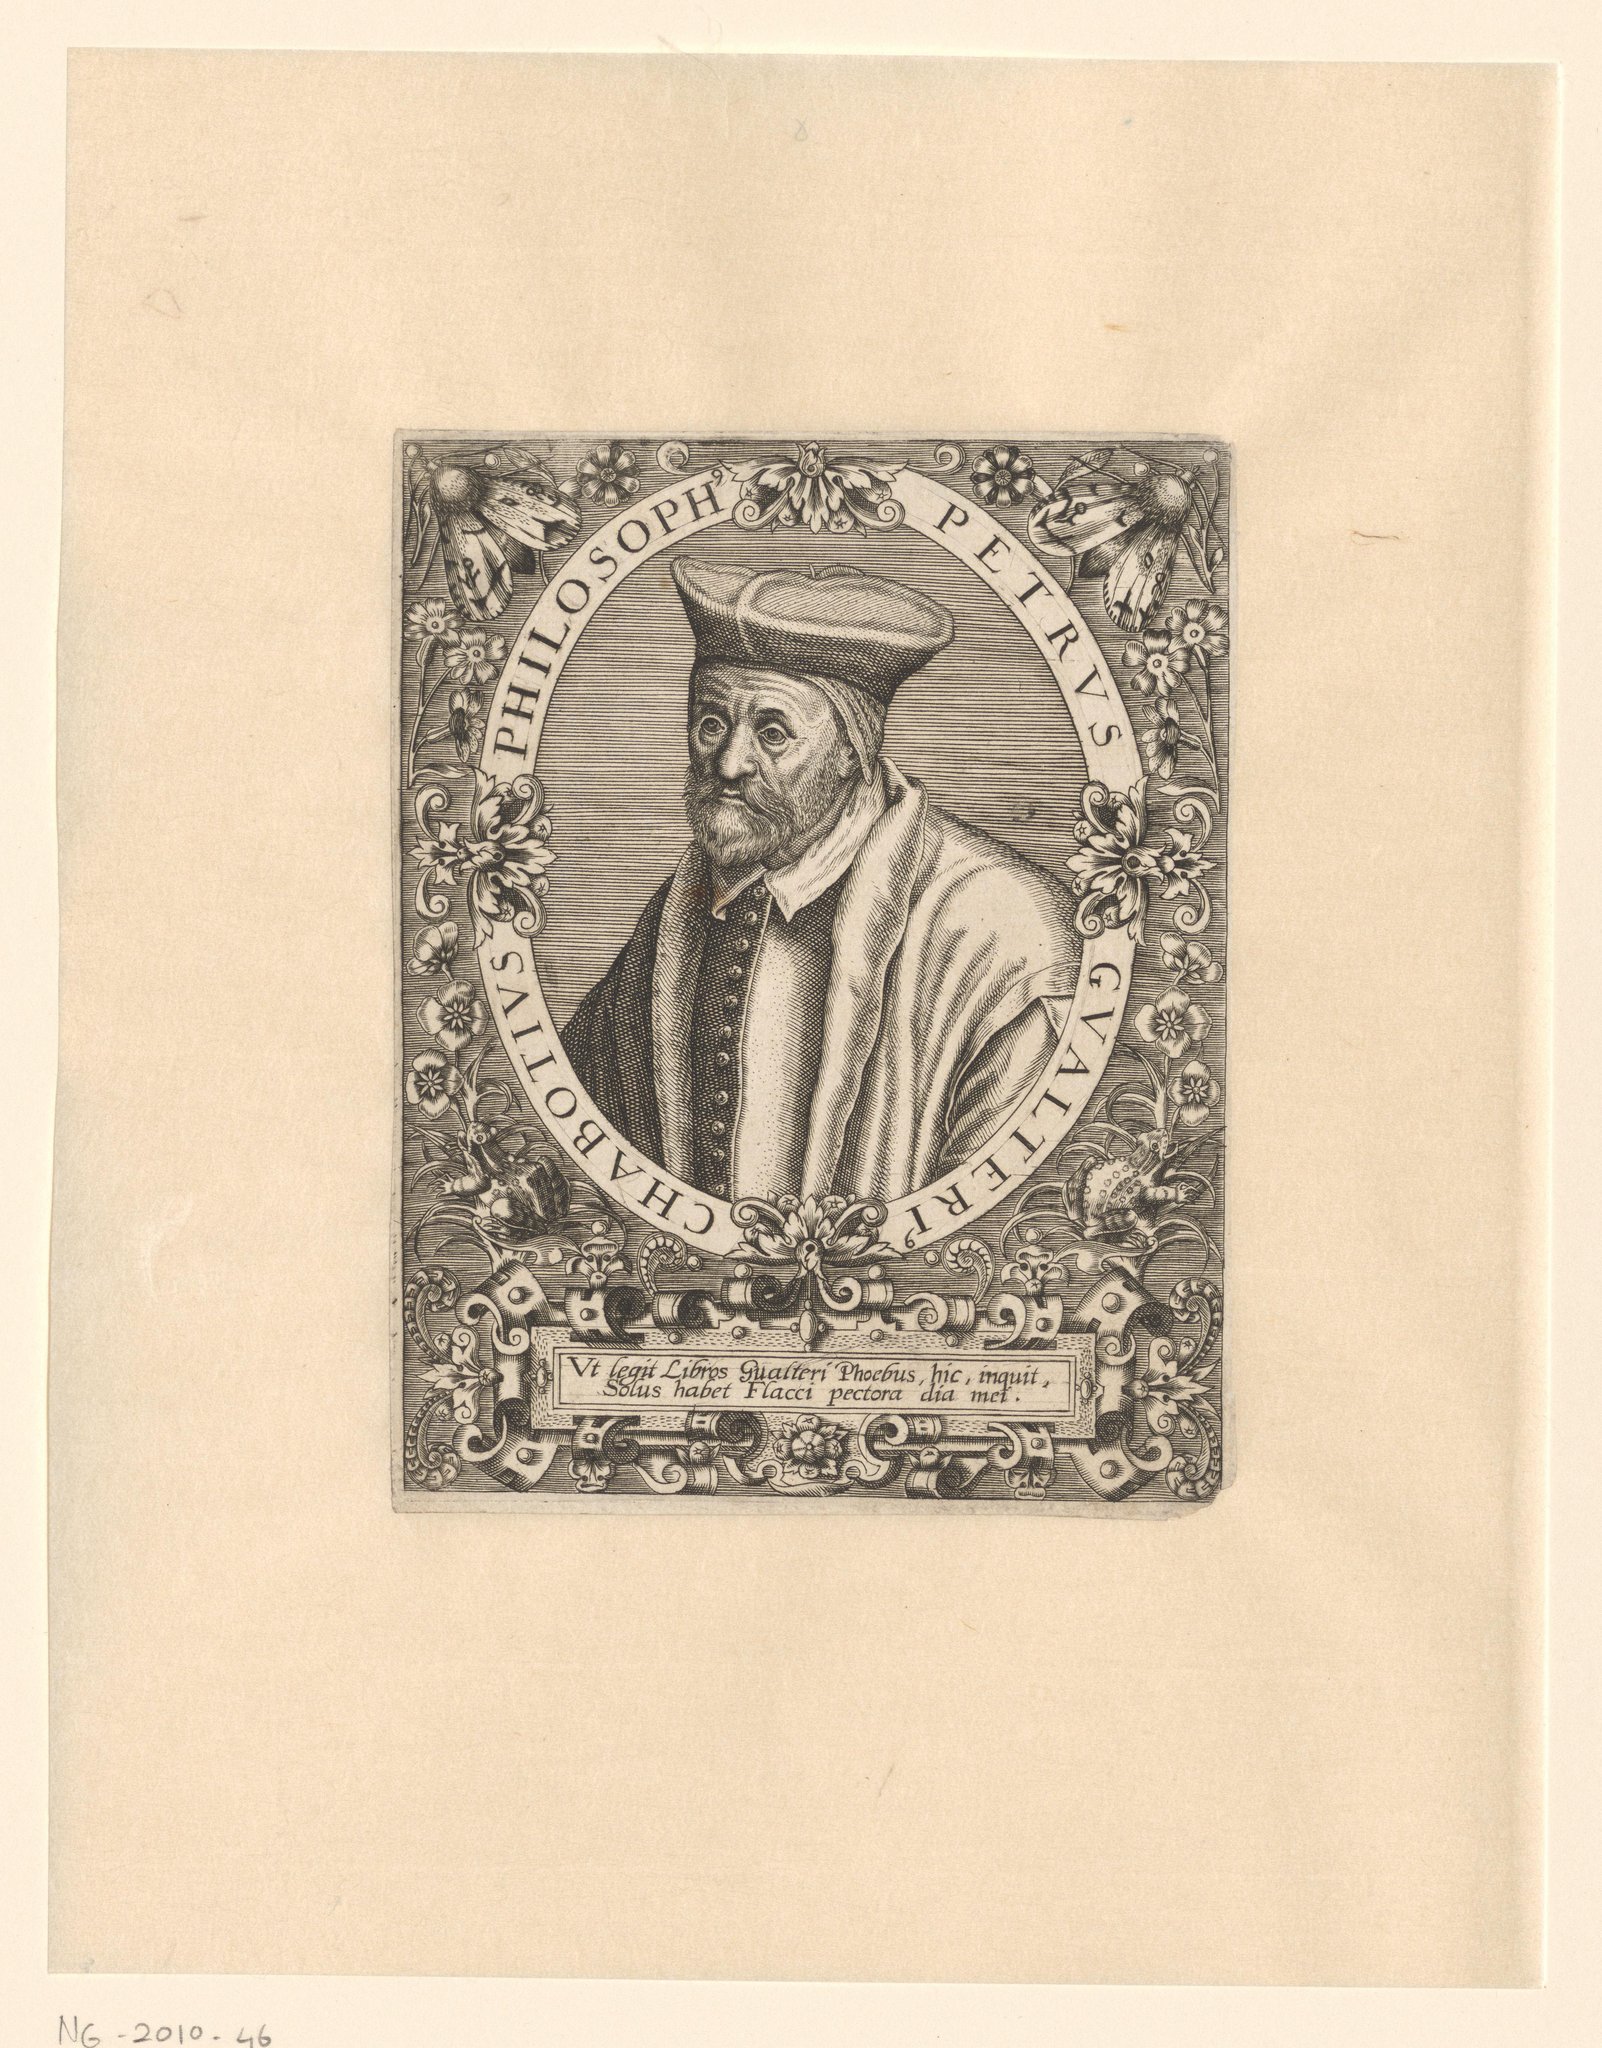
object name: print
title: Bibliotheca chalcographica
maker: johann theodor de bry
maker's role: print maker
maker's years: 1561-1623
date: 1597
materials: paper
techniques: engraving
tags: historical persons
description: Prent waarschijnlijk uit: Boissard, Jean Jacques. Icones quinquaginta virorum illustrium doctrina & eruditione praestantium ad vivum effictae. Frankfurt am Main: s.n., 1597, p. 248. Prent met nummering rechtsonder verschenen in: Boissard, Jean Jacques. Bibliotheca chalcographica. Frankfurt am Main: Johannes Ammon, 1650.